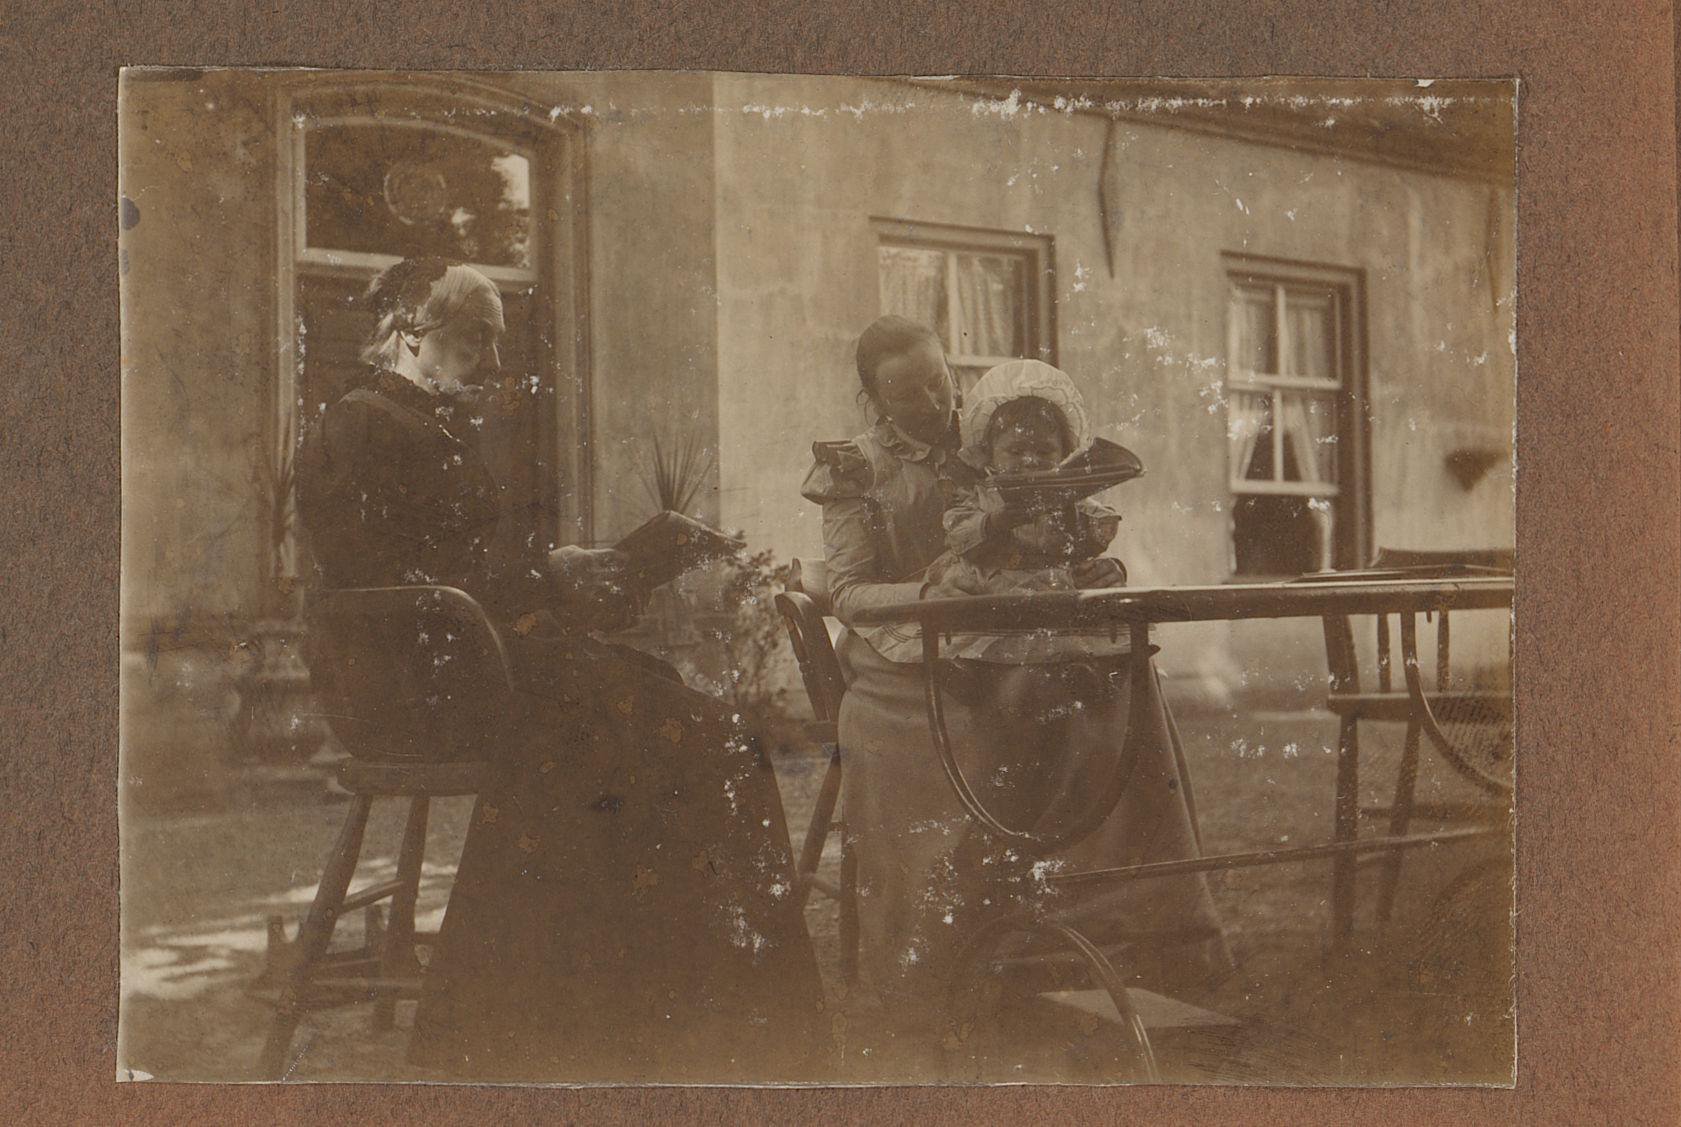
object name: photograph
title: Twee vrouwen met een kind aan een tafel buiten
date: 1880-1910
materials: photographic support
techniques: photography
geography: amsterdam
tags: netherlands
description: Foto op bruin albumblad 29 van familiealbum van Alphons Diepenbrock.